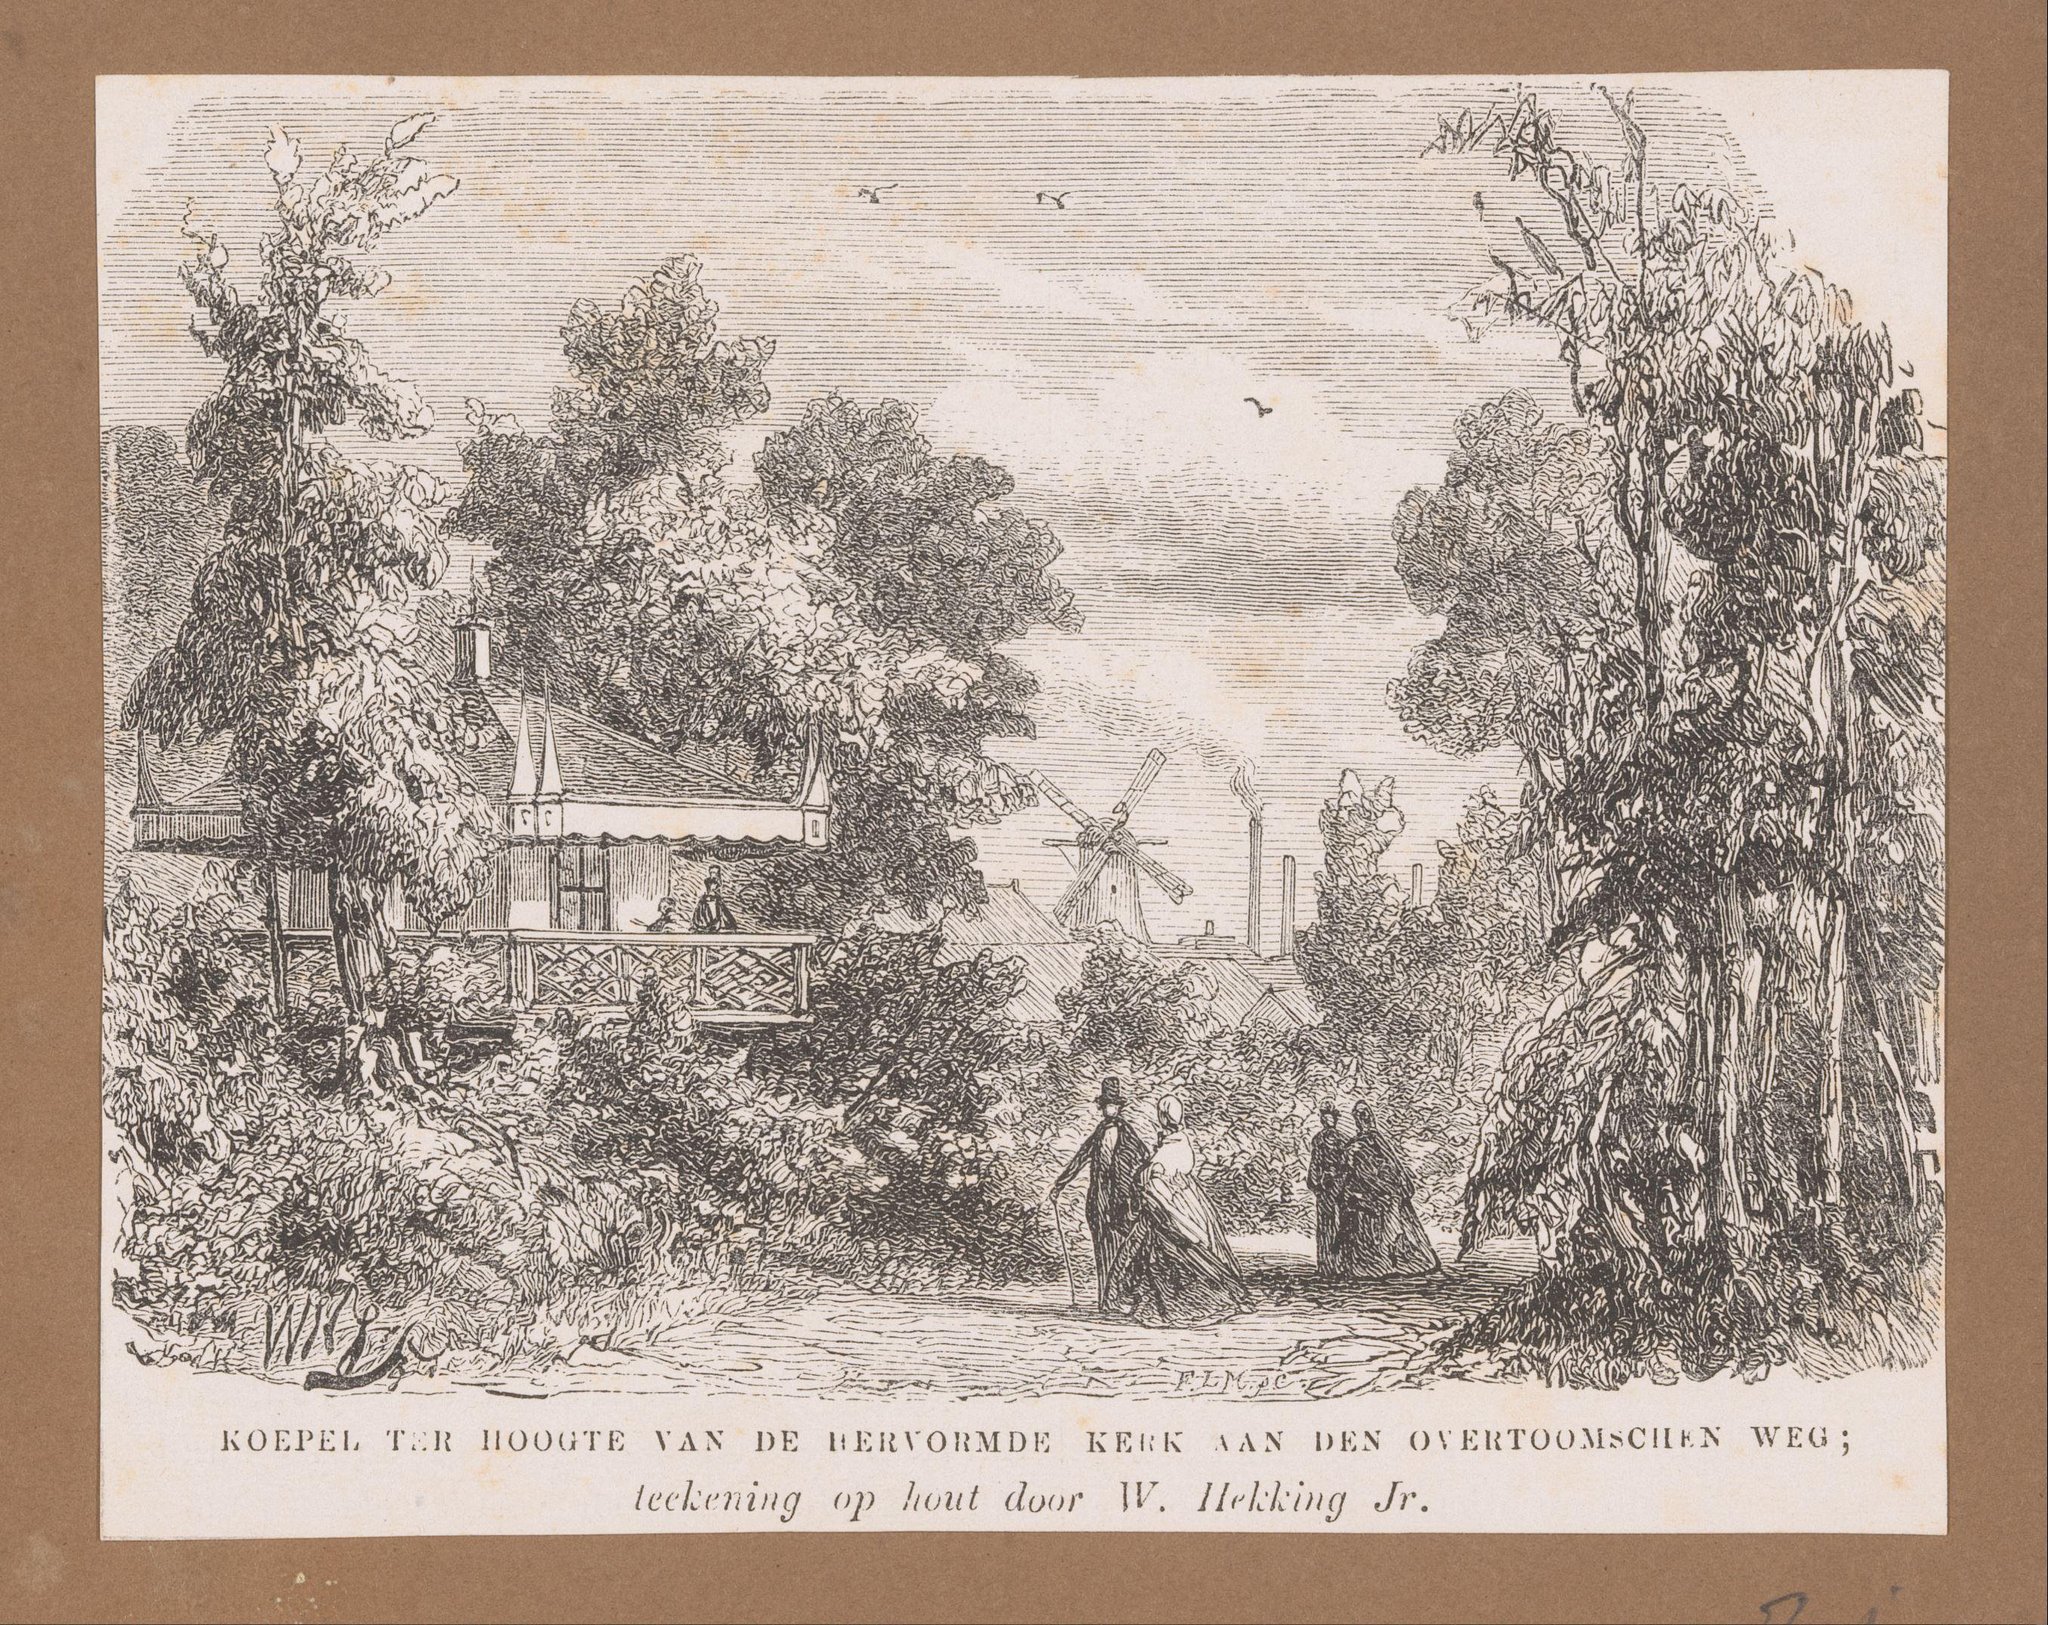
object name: print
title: Gezicht op een koepel in het park bij de Overtoom in Amsterdam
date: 1866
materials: paper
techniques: letterpress printing, engraving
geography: amsterdam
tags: park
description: Prent uit: Witkamp, P.H. 'Het Rij en Wandelpark te Amsterdam', Het Nederlandsch Magazijn (1866), nr. 10, p. 76.